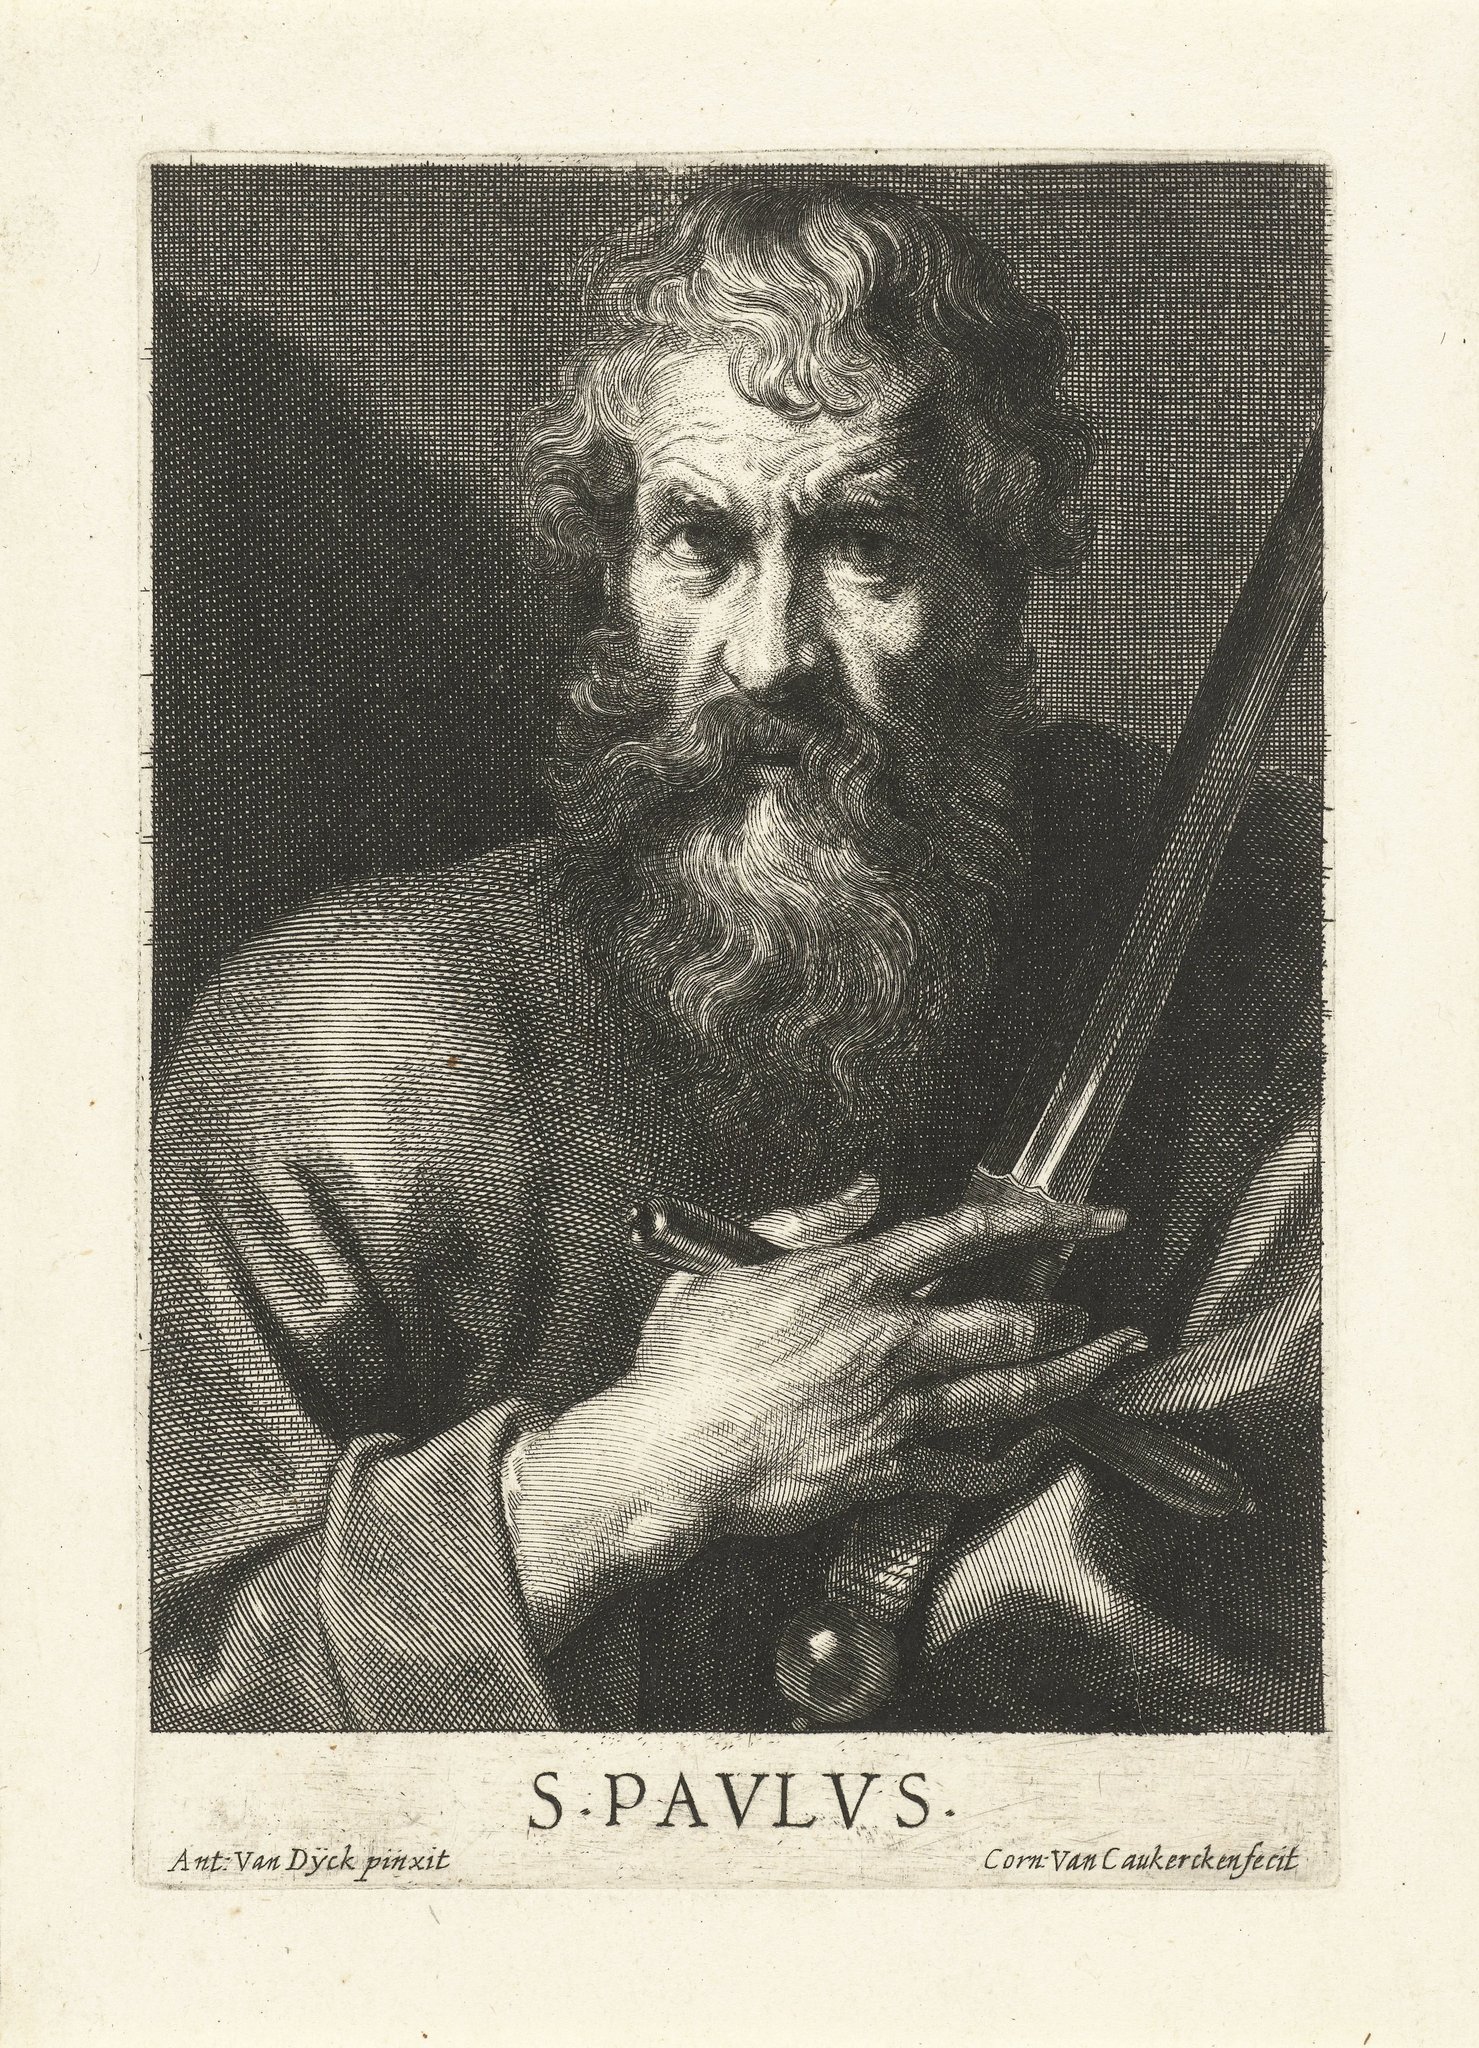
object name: print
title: Christus en de apostelen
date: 1640-1680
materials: paper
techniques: engraving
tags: the apostle paul of tarsus; possible attributes: book, scroll, sword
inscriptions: collector's mark: Lugt 240